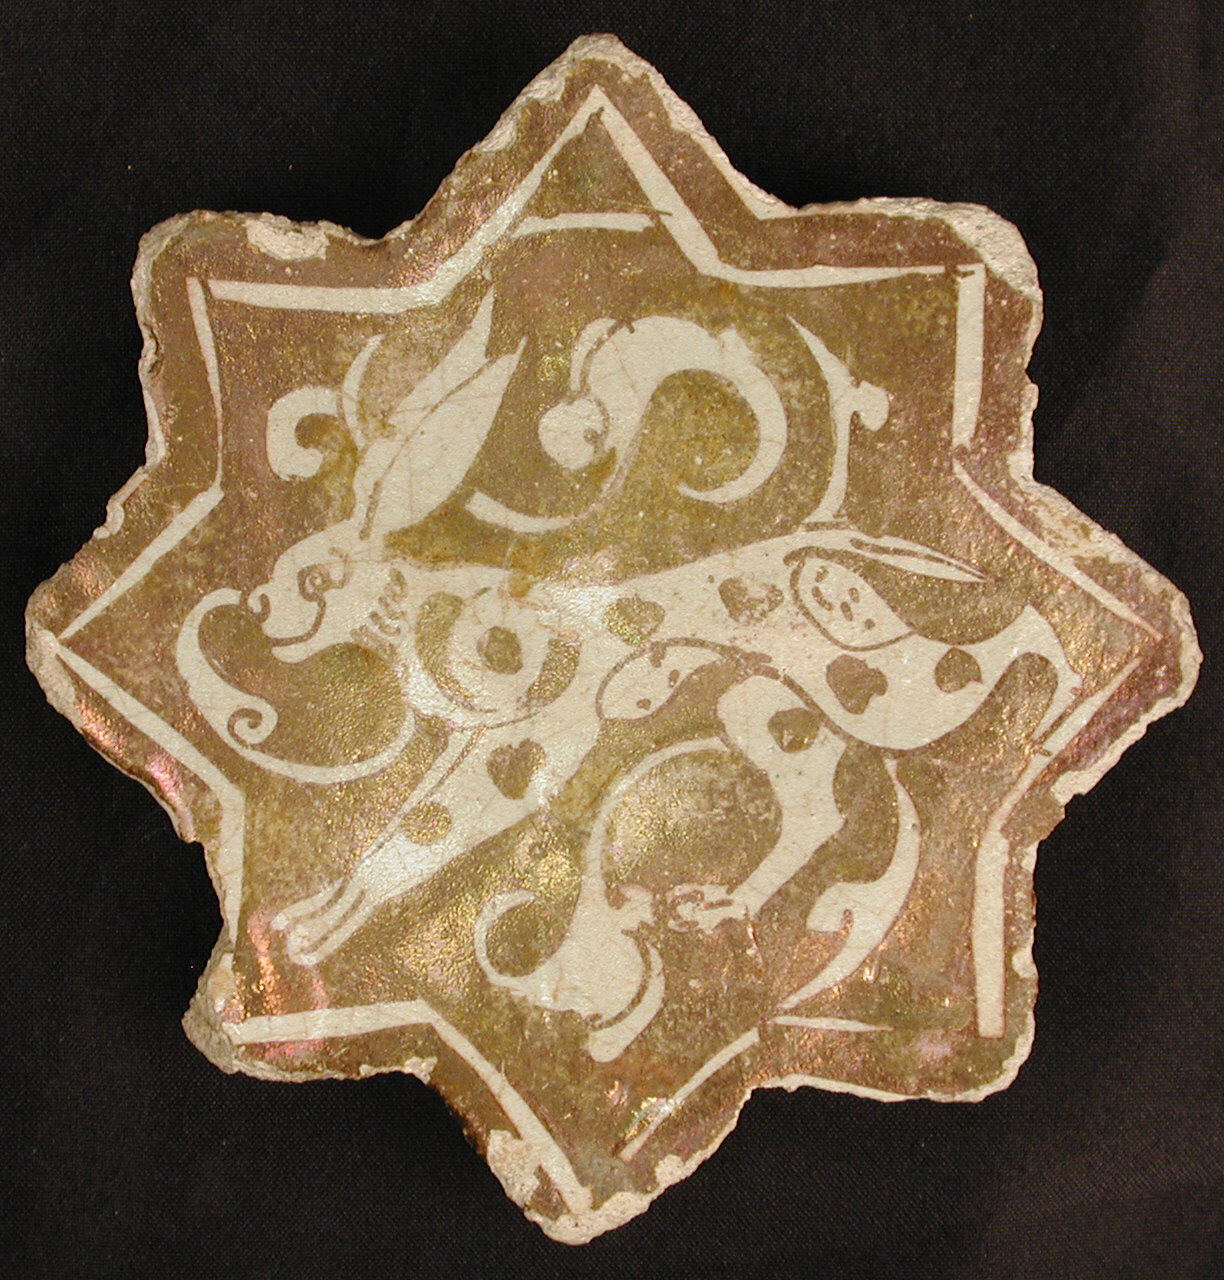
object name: star shaped tile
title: Star-Shaped Tile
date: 1101-1200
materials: stonepaste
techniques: luster painting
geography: iran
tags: rabbits